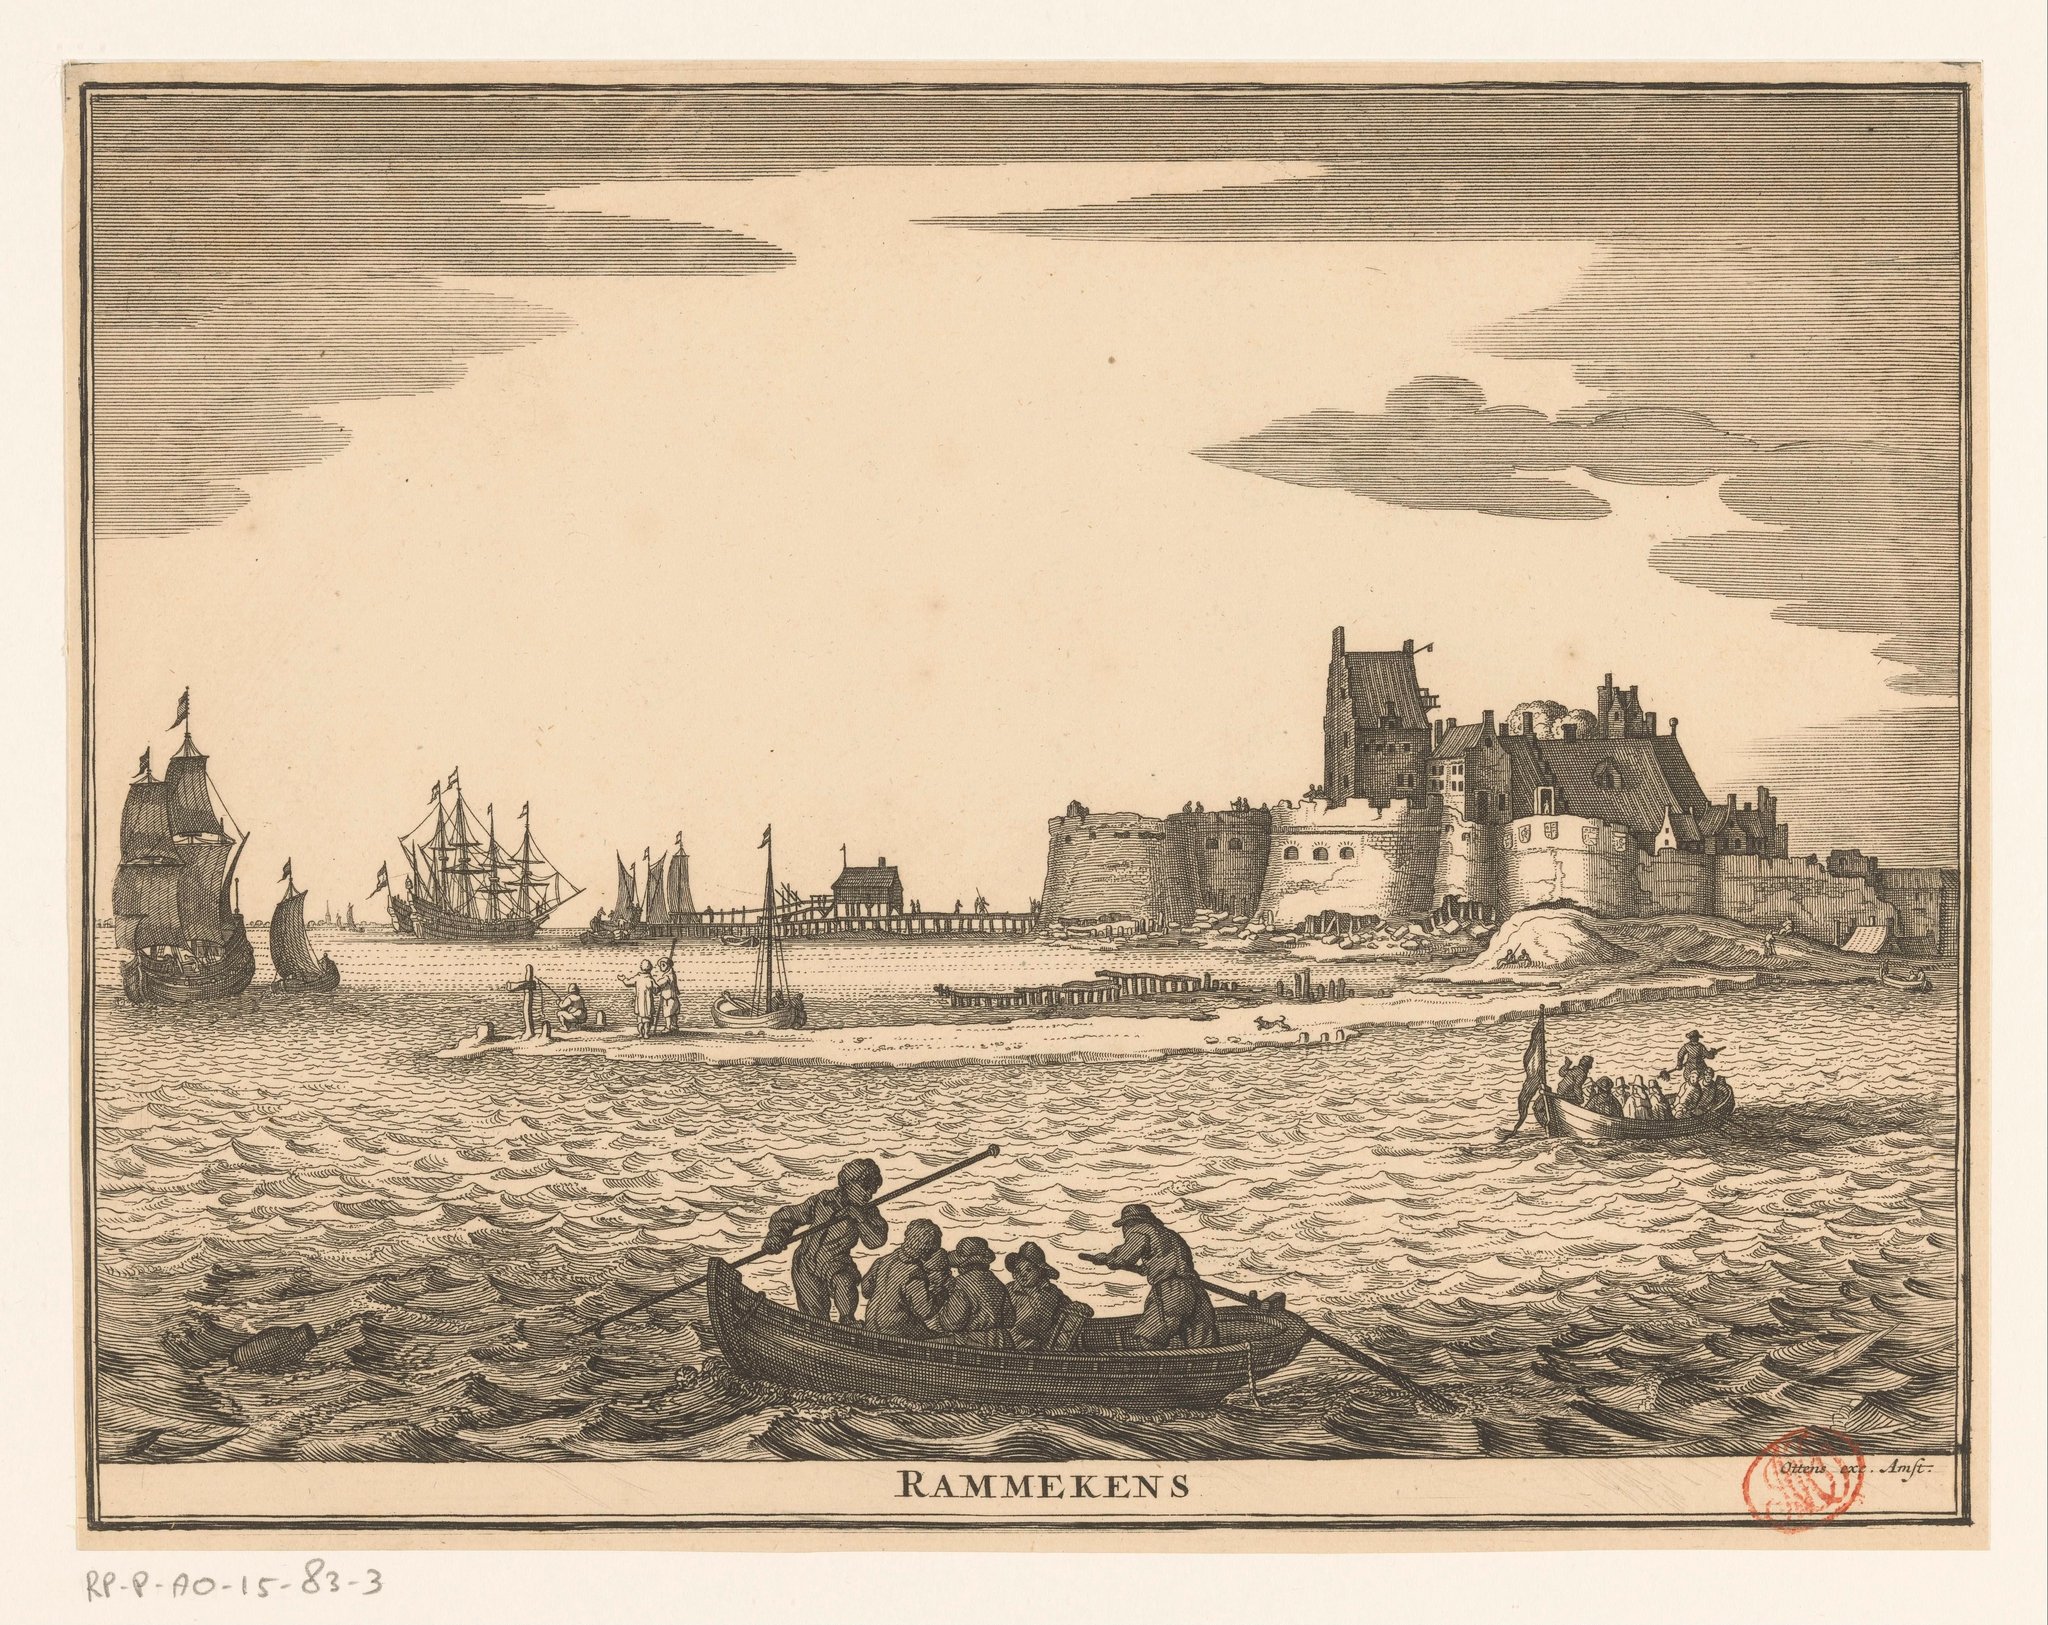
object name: print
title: Gezicht op Fort Rammekens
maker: pieter hendricksz. schut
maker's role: print maker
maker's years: 1618-1660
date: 1657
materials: paper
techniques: engraving, etching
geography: amsterdam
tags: fortress, city-view, and landscape with man-made constructions, sailing-ship, sailing-boat, rowing-boat, canoe, etc.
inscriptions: collector's mark: Lugt 195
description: Prent ook gebruikt in: Speculum Zelandiae dat is een beschryvinge ofte afbeelding der steden, ambachts-heerlijckheden, dorpen castelen, ridderlijcke hofsteden, huysen en gebouwen gelegen inde eylanden en de graeflijckheyt van Zeelandt. Amsterdam: weduwe Ottens en Zoonen, s.a. [1719-1725]. Eerdere staat/staten van prent is/zijn gebruikt in eerdere uitgaven van 'Speculum Zelandiae' en in andere publicaties uitgegeven door Zacharias Roman en Nicolaes Visscher (I). De eerste publicatie waarin de eerste staat van de huidige prent voorkomt dateert uit 1657. Verwarring rondom de datering kan ontstaan door het feit de prenten uit 'Speculum Zelandiae' ook voorkomen in eerder uitgegeven publicaties, waar ze later in zijn ingebonden. Zo komen prenten uitgegeven door Roman/Visscher voor in sommige exemplaren van: Boxhorn, Marcus Zuerius van. Chroniick van Zeelandt (…). 2 delen. Middelburg: Zacharias Roman, 1644. De door weduwe (Joachim) Ottens en Zoonen uitgegeven prenten zijn later ingebonden in sommige exemplaren van: Smallegange, Mattheus. Nieuwe Cronyk van Zeeland (…). Middelburg en Amsterdam: Johannes Meertens en Abraham van Someren, 1696. Zie RP-P-AO-15-83-1 voor eerste staat.